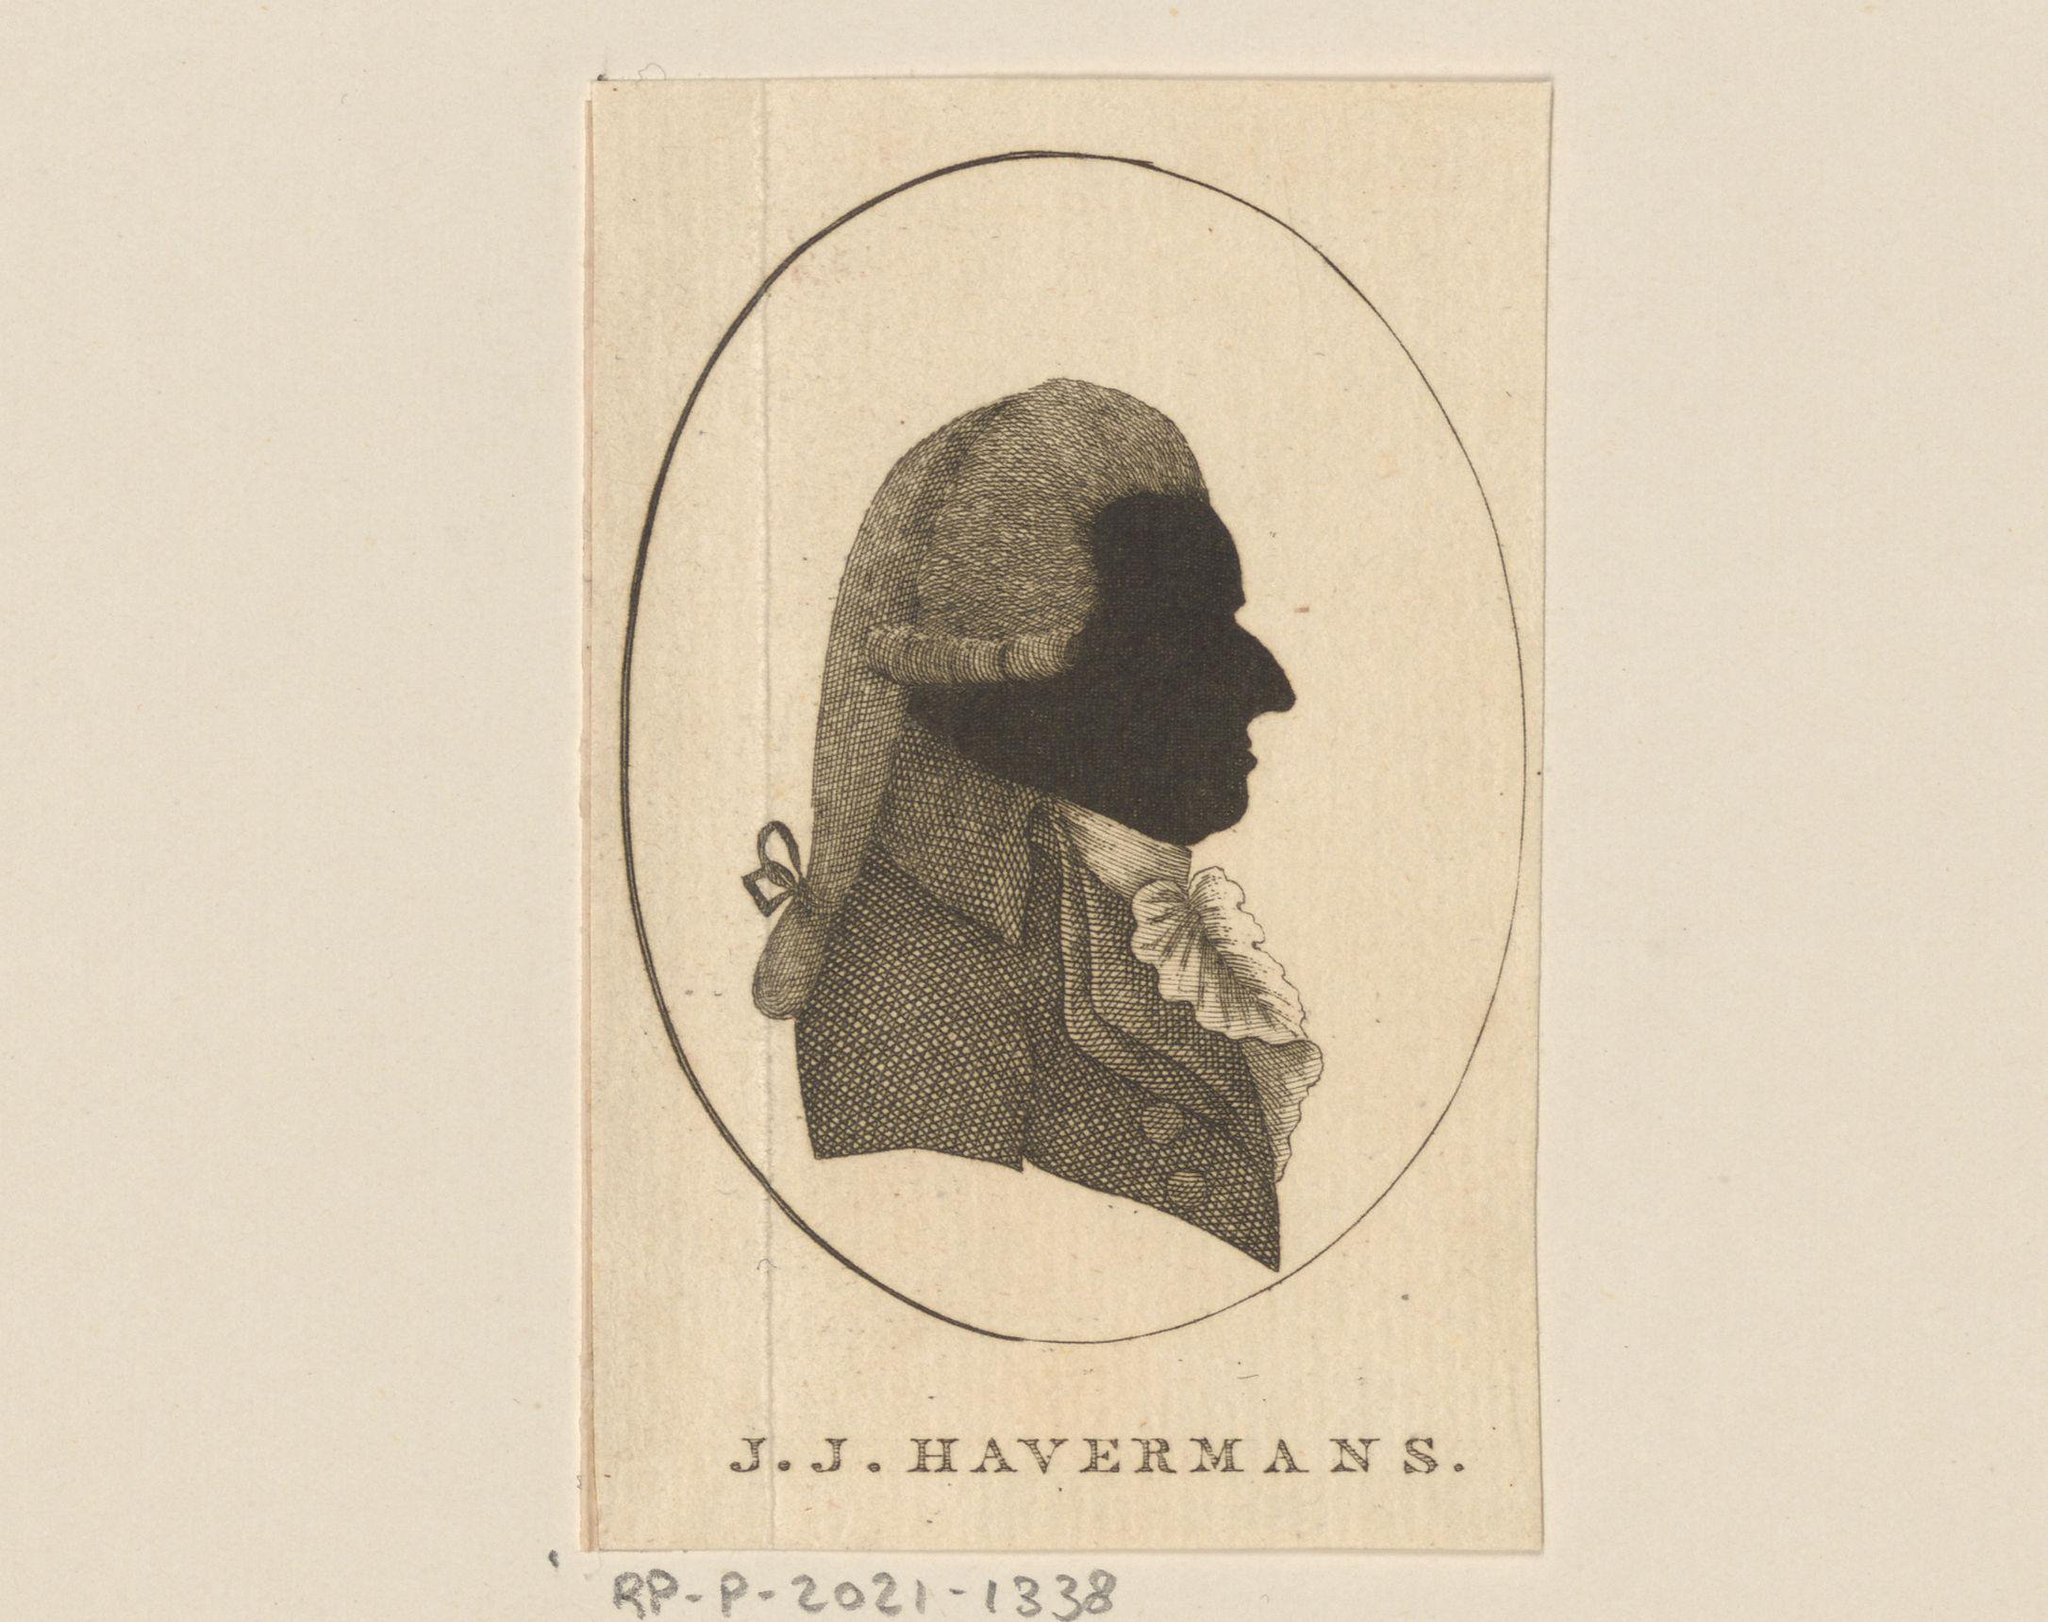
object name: print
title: Silhouetportret van Johannes Josephus Havermans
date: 1799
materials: paper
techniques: etching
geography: amsterdam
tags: historical persons, politician, e.g. party leader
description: Prent uit: Rogge, Cornelis. Geschiedenis der staatsregeling, voor het Bataafsche volk. Amsterdam: Johannes Allart, 1799.